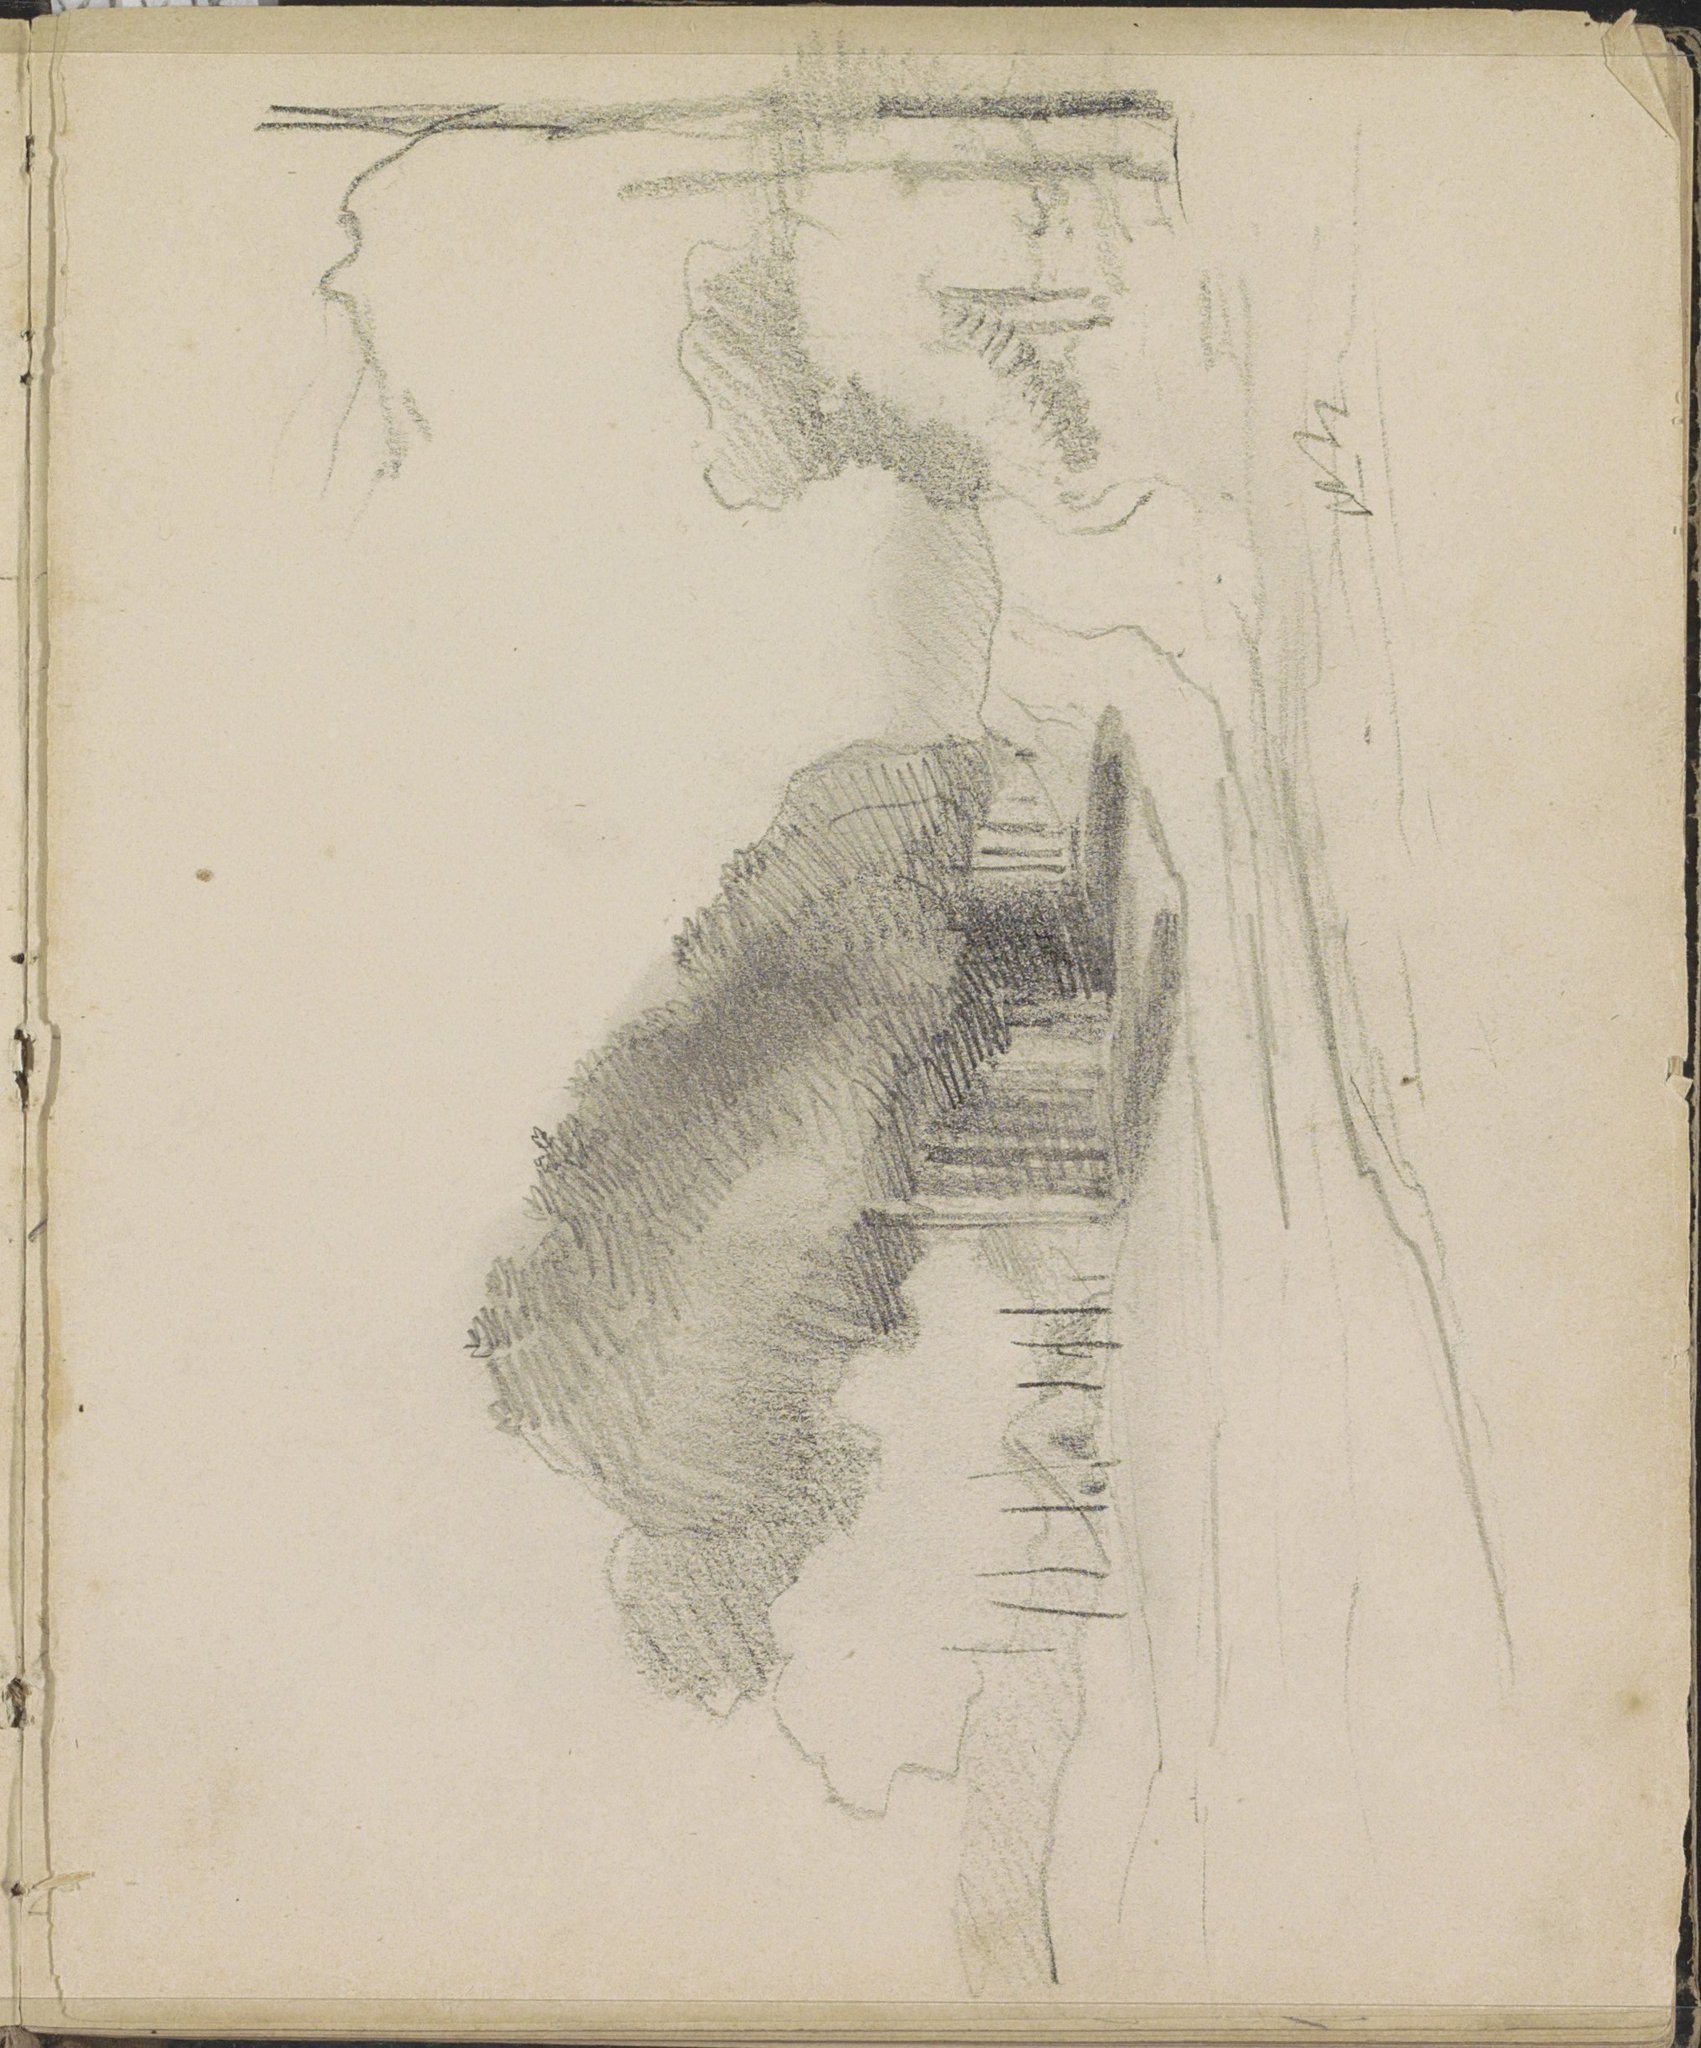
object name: sketchbook leaf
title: Laan in een landschap met bomen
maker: johannes tavenraat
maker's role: draughtsman, painter, print maker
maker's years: 1809-1881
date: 1841-1853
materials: paper, pencil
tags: trees, landscapes, forest path or lane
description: Blad 2 recto uit een schetsboek met 87 bladen.